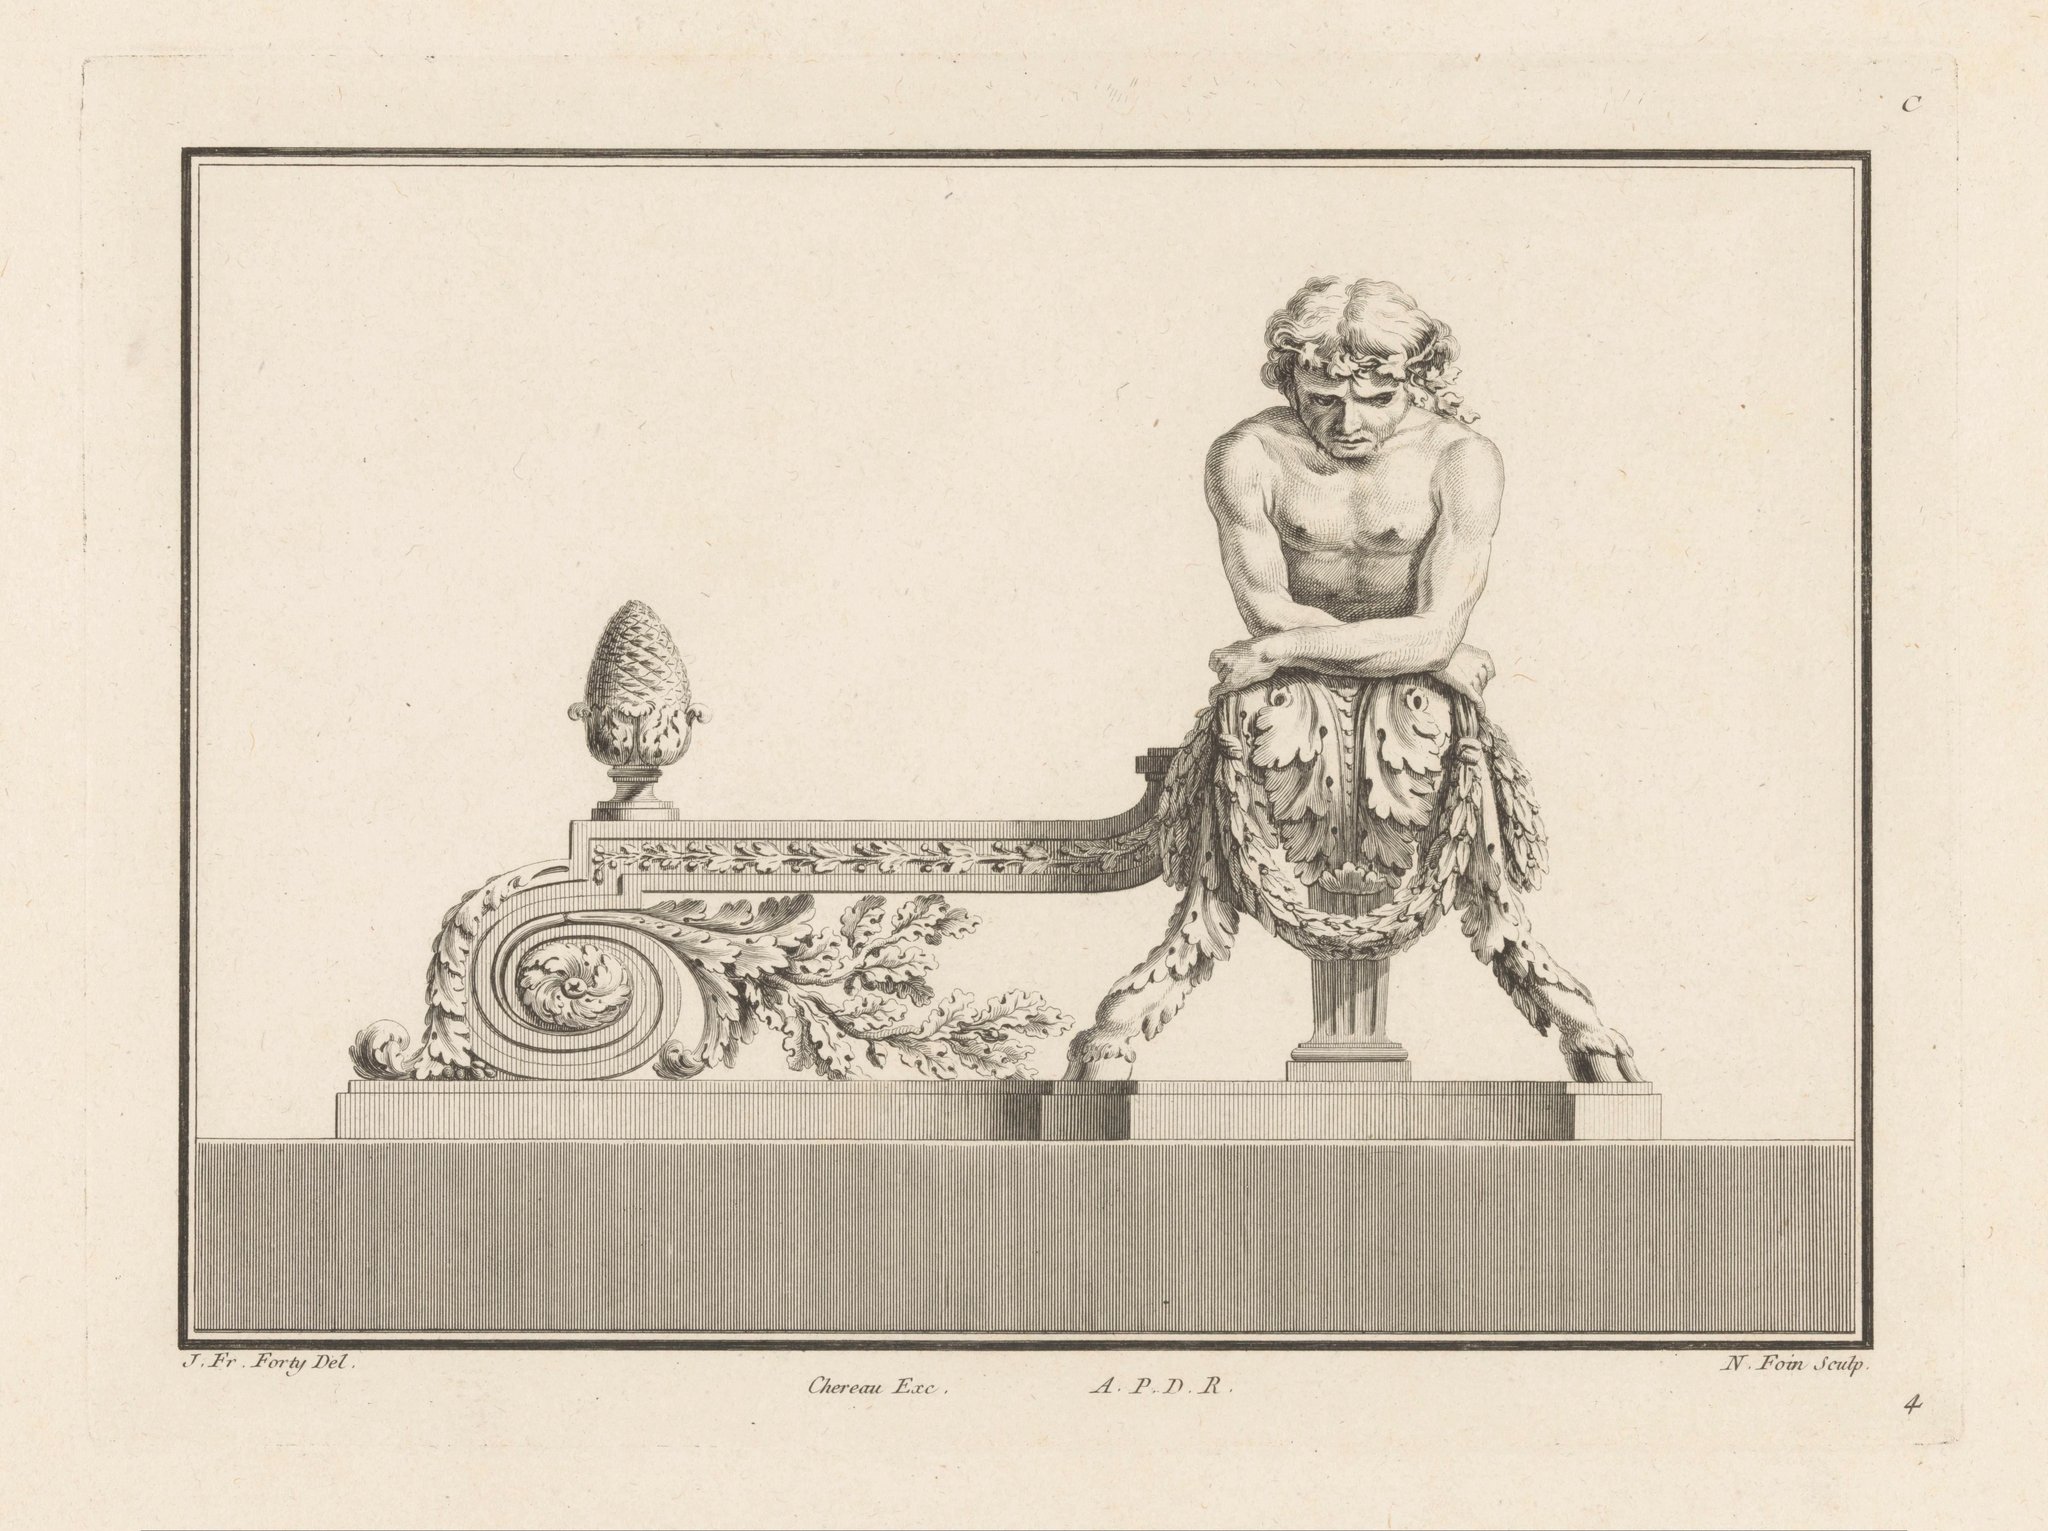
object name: ornament print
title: Oeuvres de Sculptures en Bronze, Contenant Girandoles, Flambeaux, Feux (...)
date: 1775-1790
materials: paper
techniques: engraving, etching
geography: paris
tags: leaning forward, andiron, fire-dog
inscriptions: collector's mark: Lugt 2228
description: Een geornamenteerde vuurbok met rechts een man leunend op ranken en bokkenpoten. Links een dennenappel.